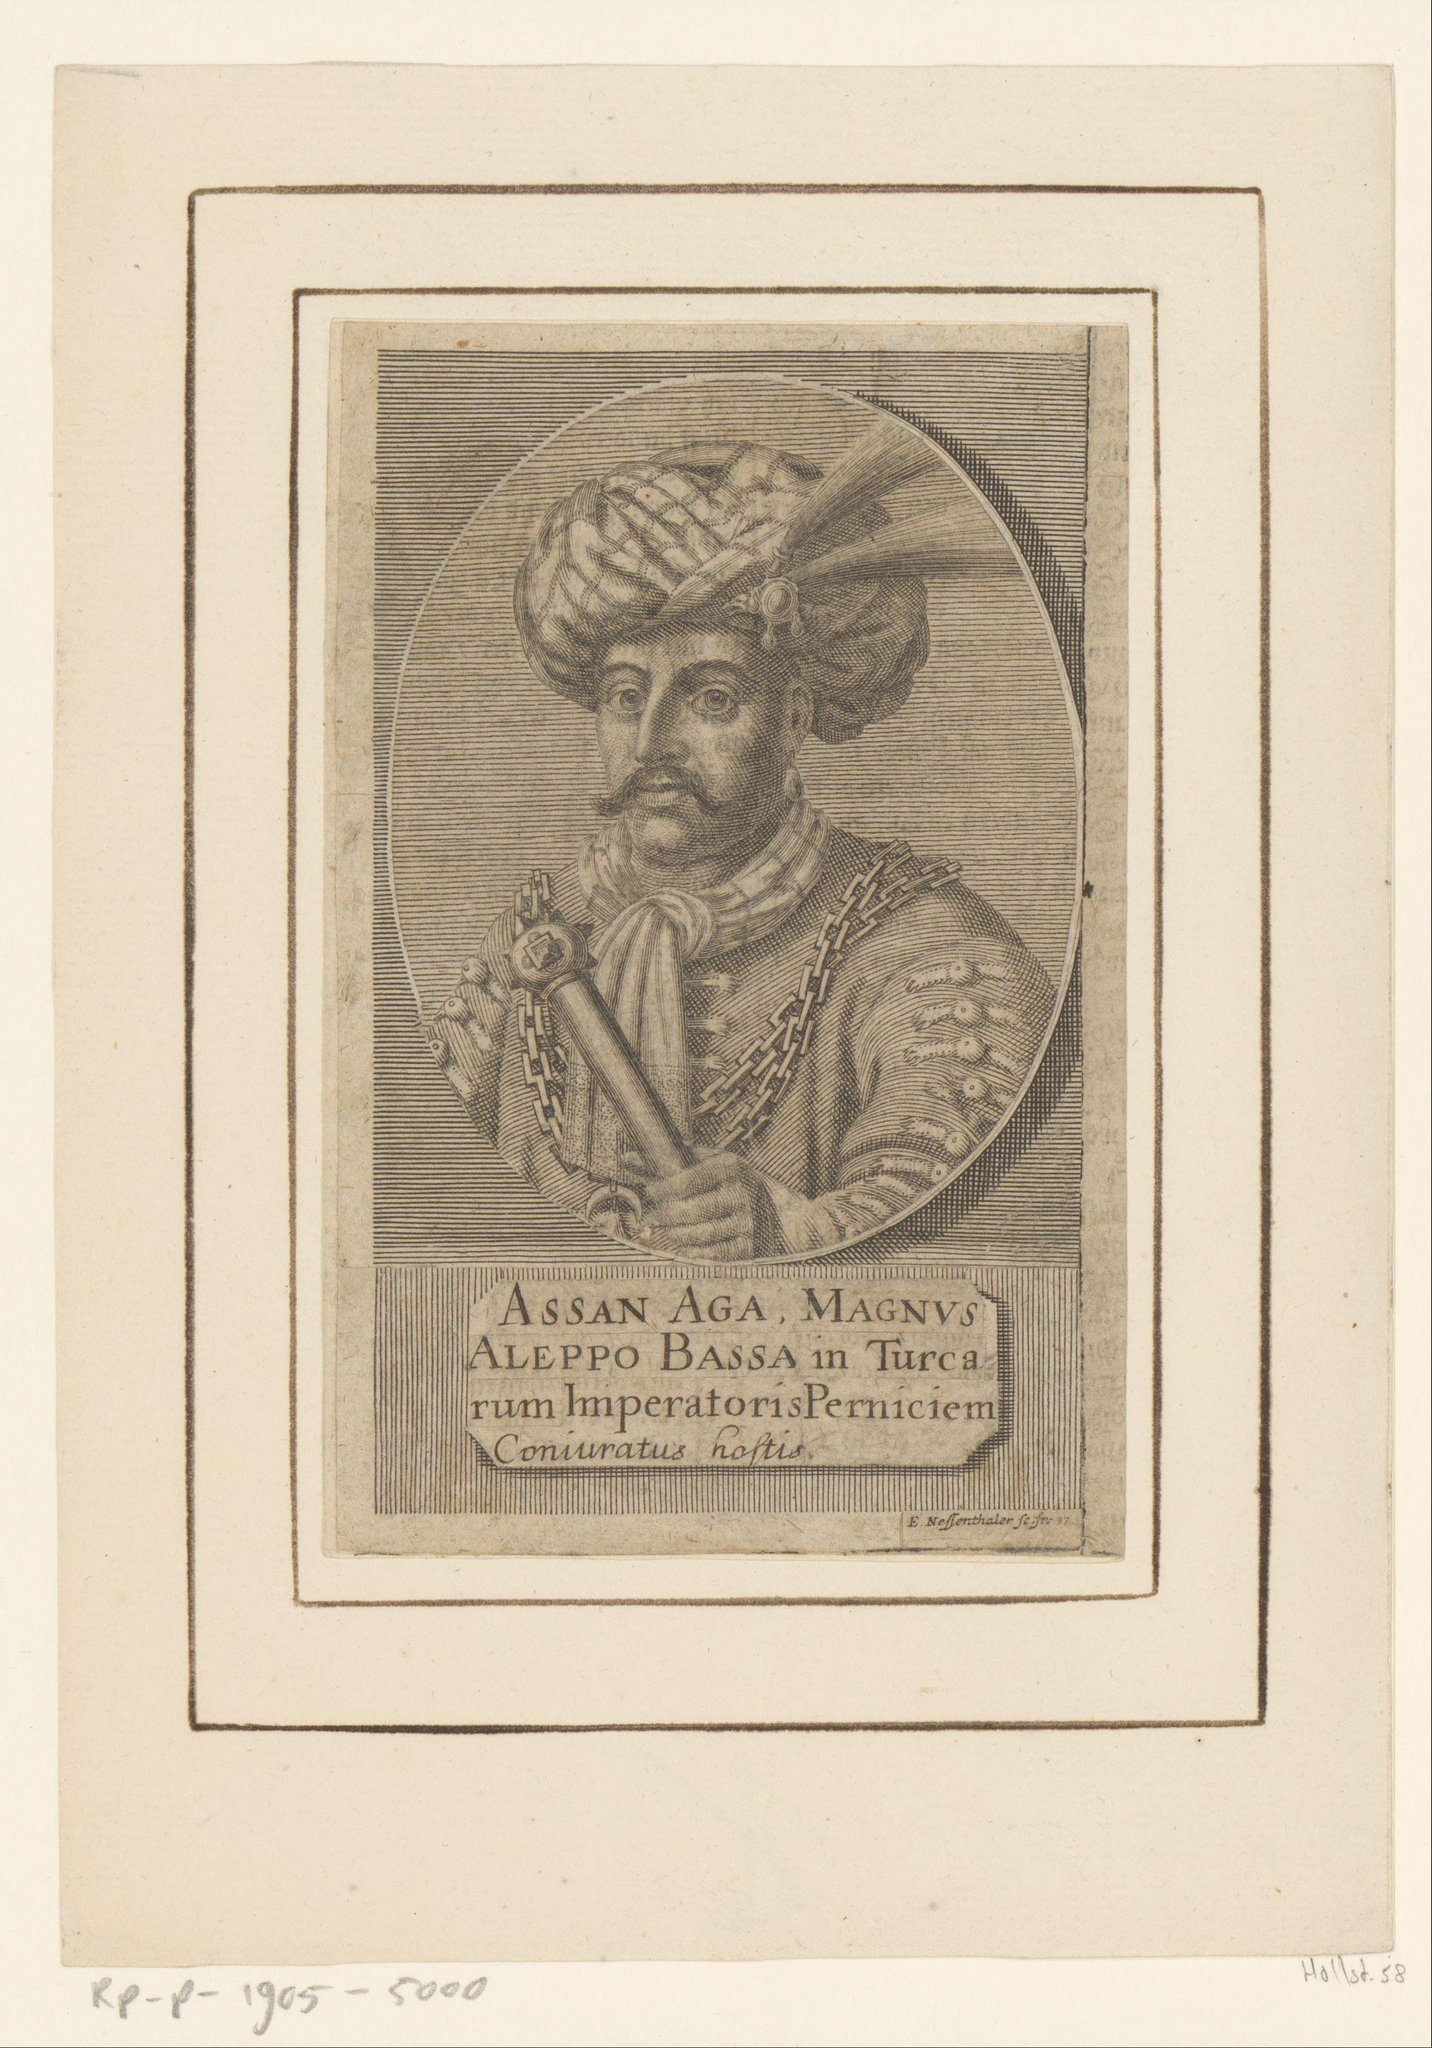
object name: print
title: Portret van Hassan Aga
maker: elias nessenthaler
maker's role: print maker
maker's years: 1664-1714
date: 1674-1714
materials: paper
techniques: engraving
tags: historical persons, head-gear: turban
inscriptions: collector's mark: Lugt 2228